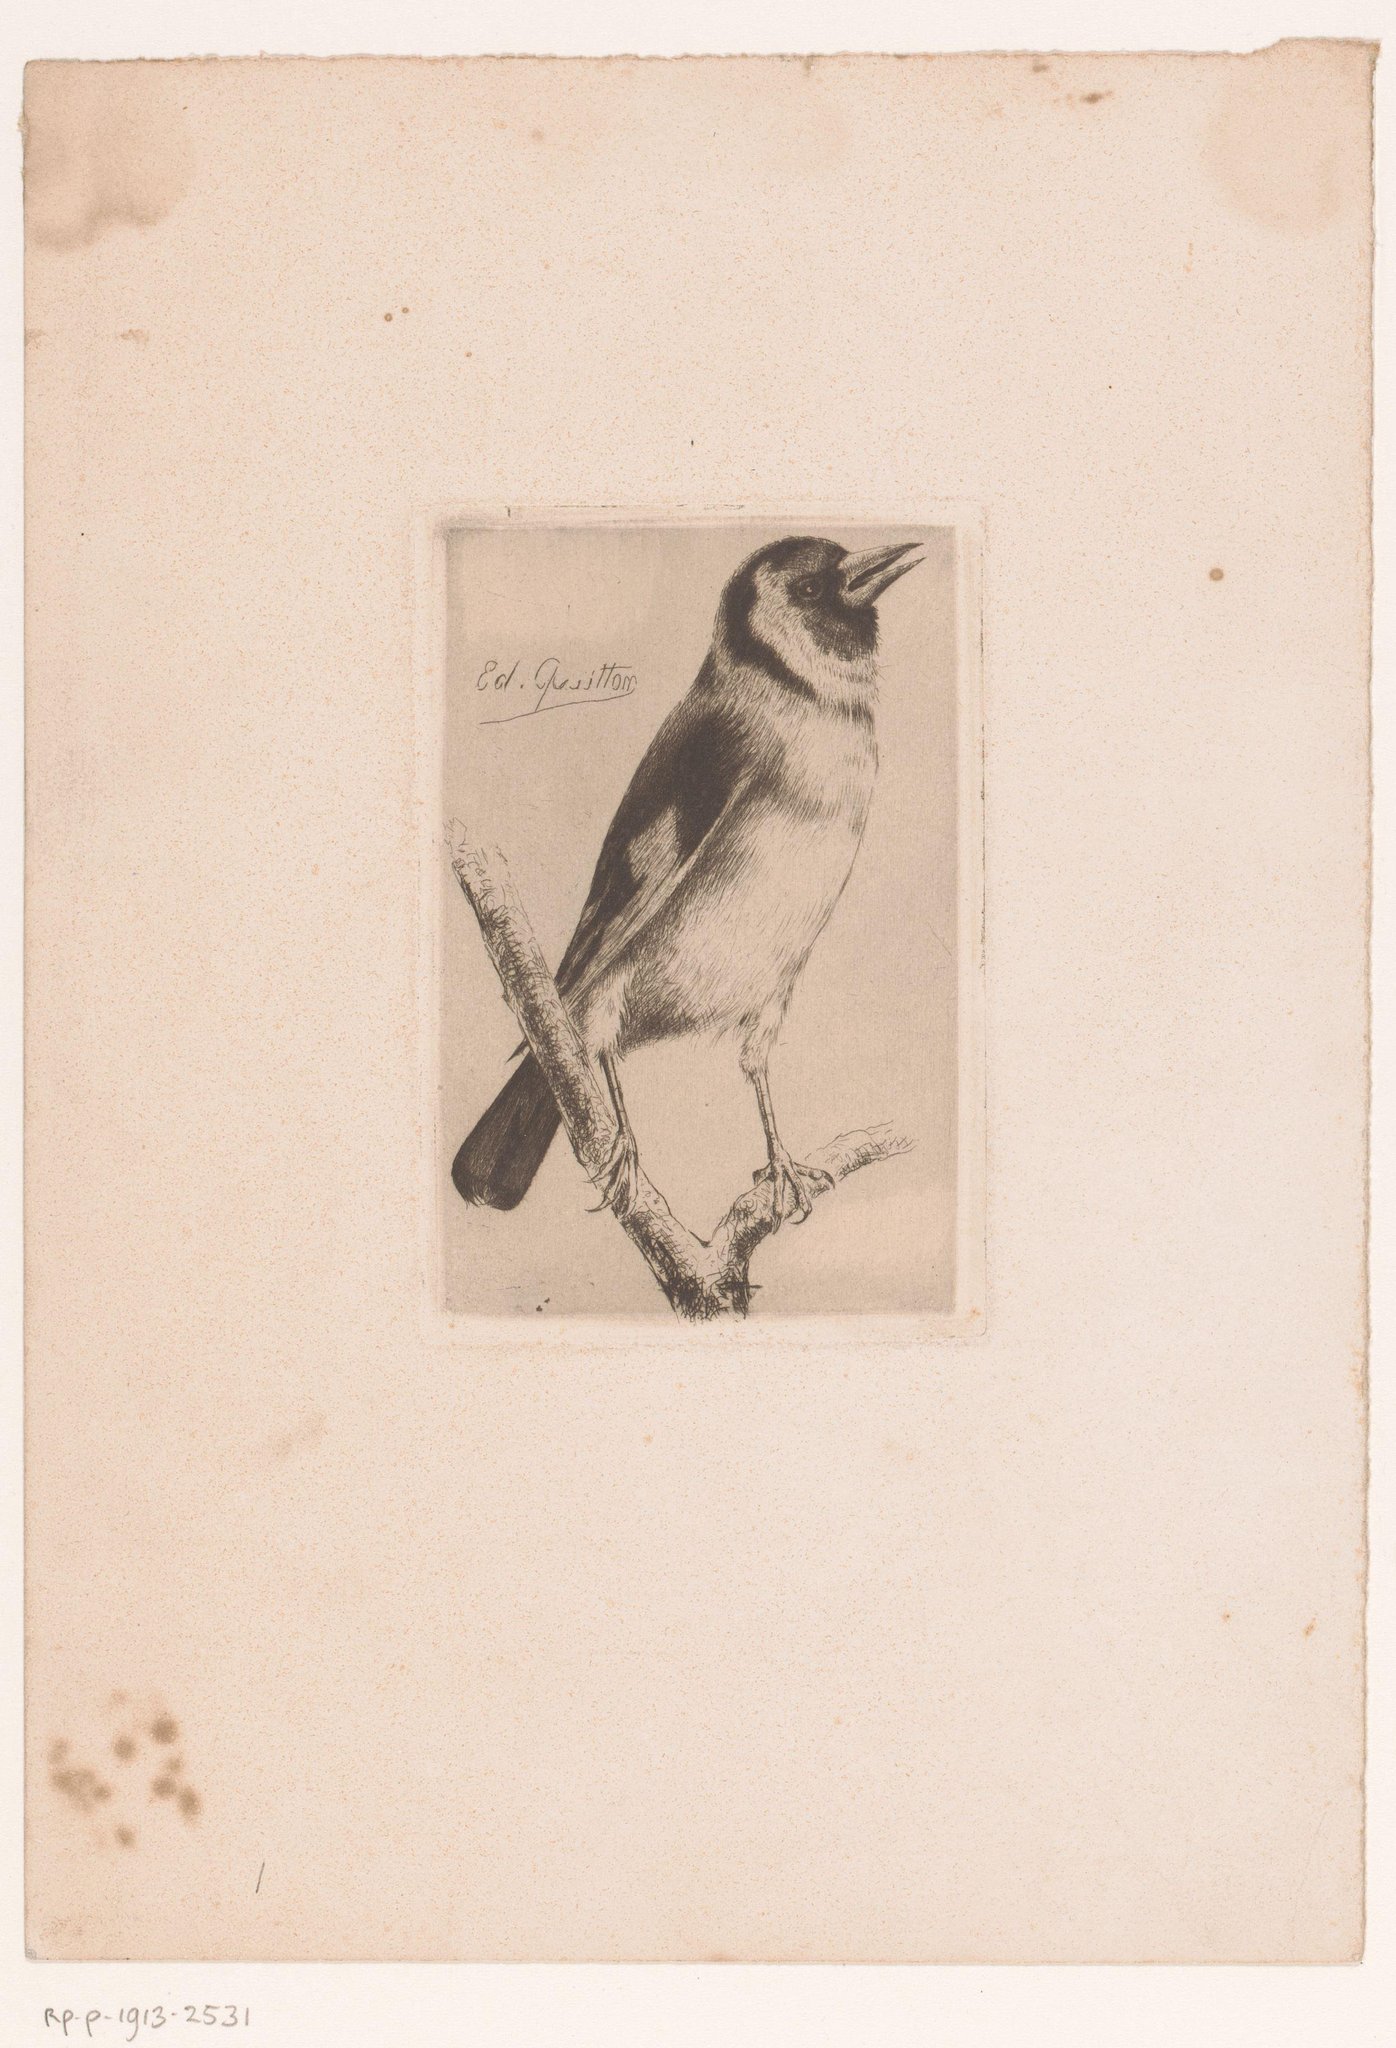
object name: print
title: Vogel op een tak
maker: edward quitton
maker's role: print maker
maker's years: 1842-1934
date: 1852-1913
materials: paper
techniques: drypoint, etching, intaglio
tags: birds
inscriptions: collector's mark: Lugt 2228